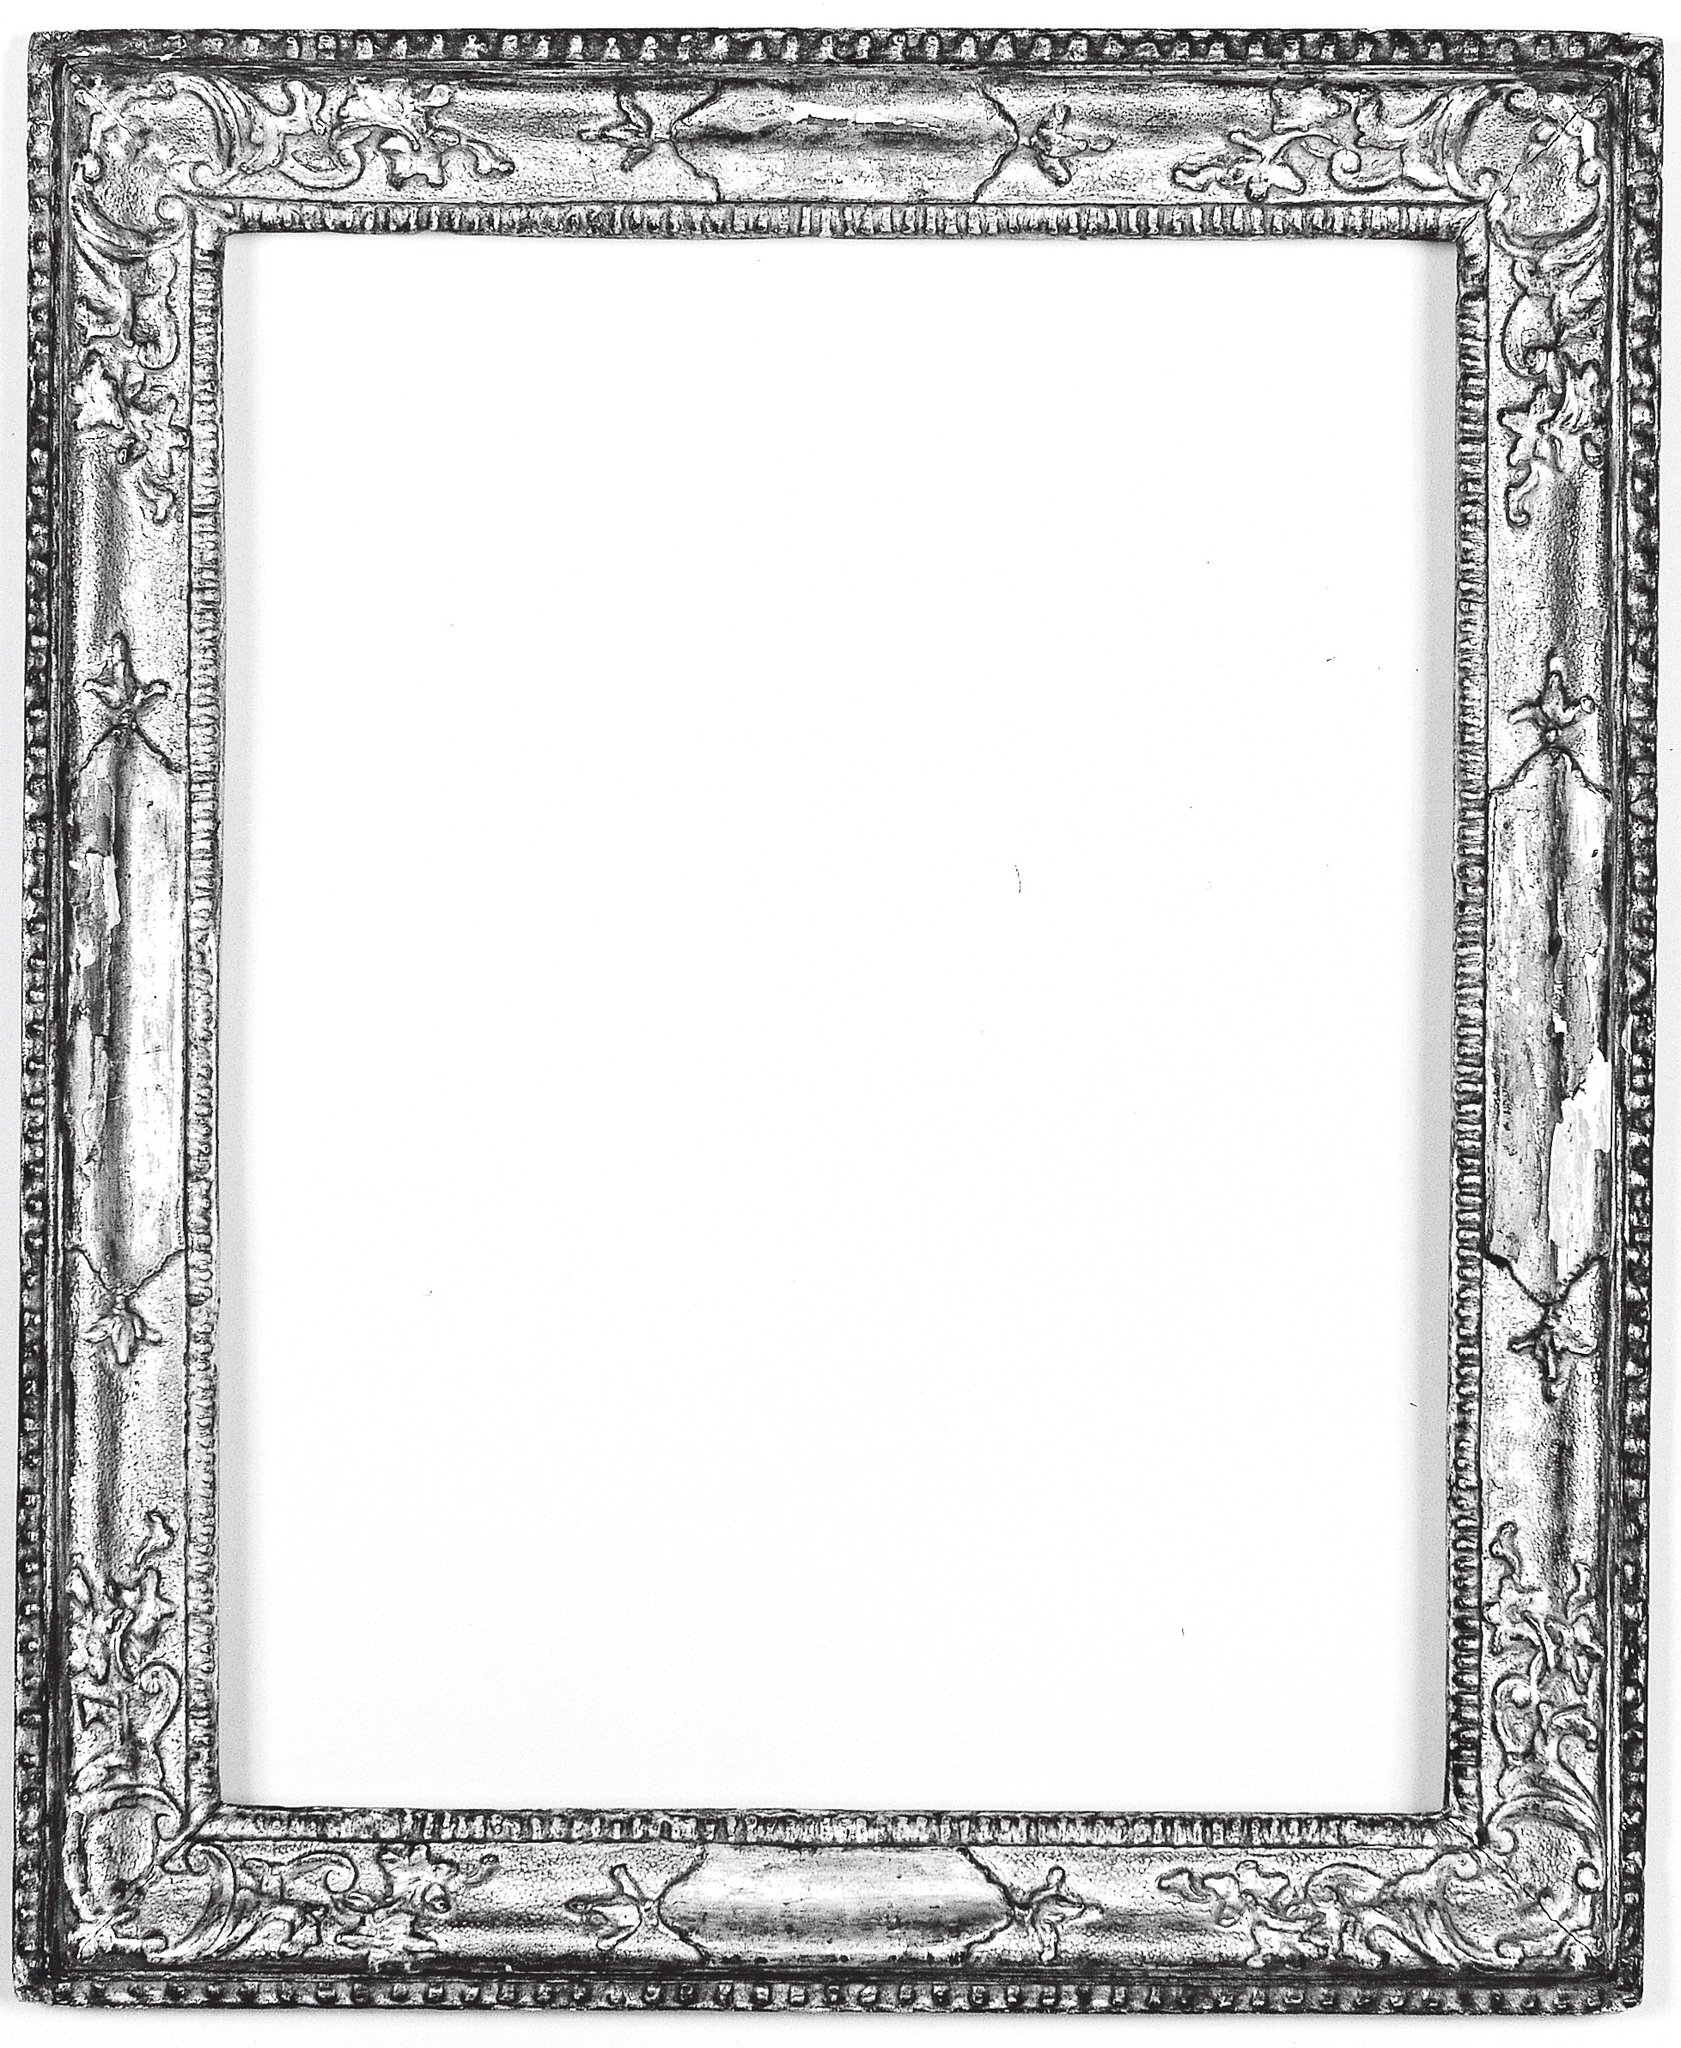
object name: frame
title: Canaletto Frame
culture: italian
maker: italian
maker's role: artist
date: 1701-1733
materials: wood